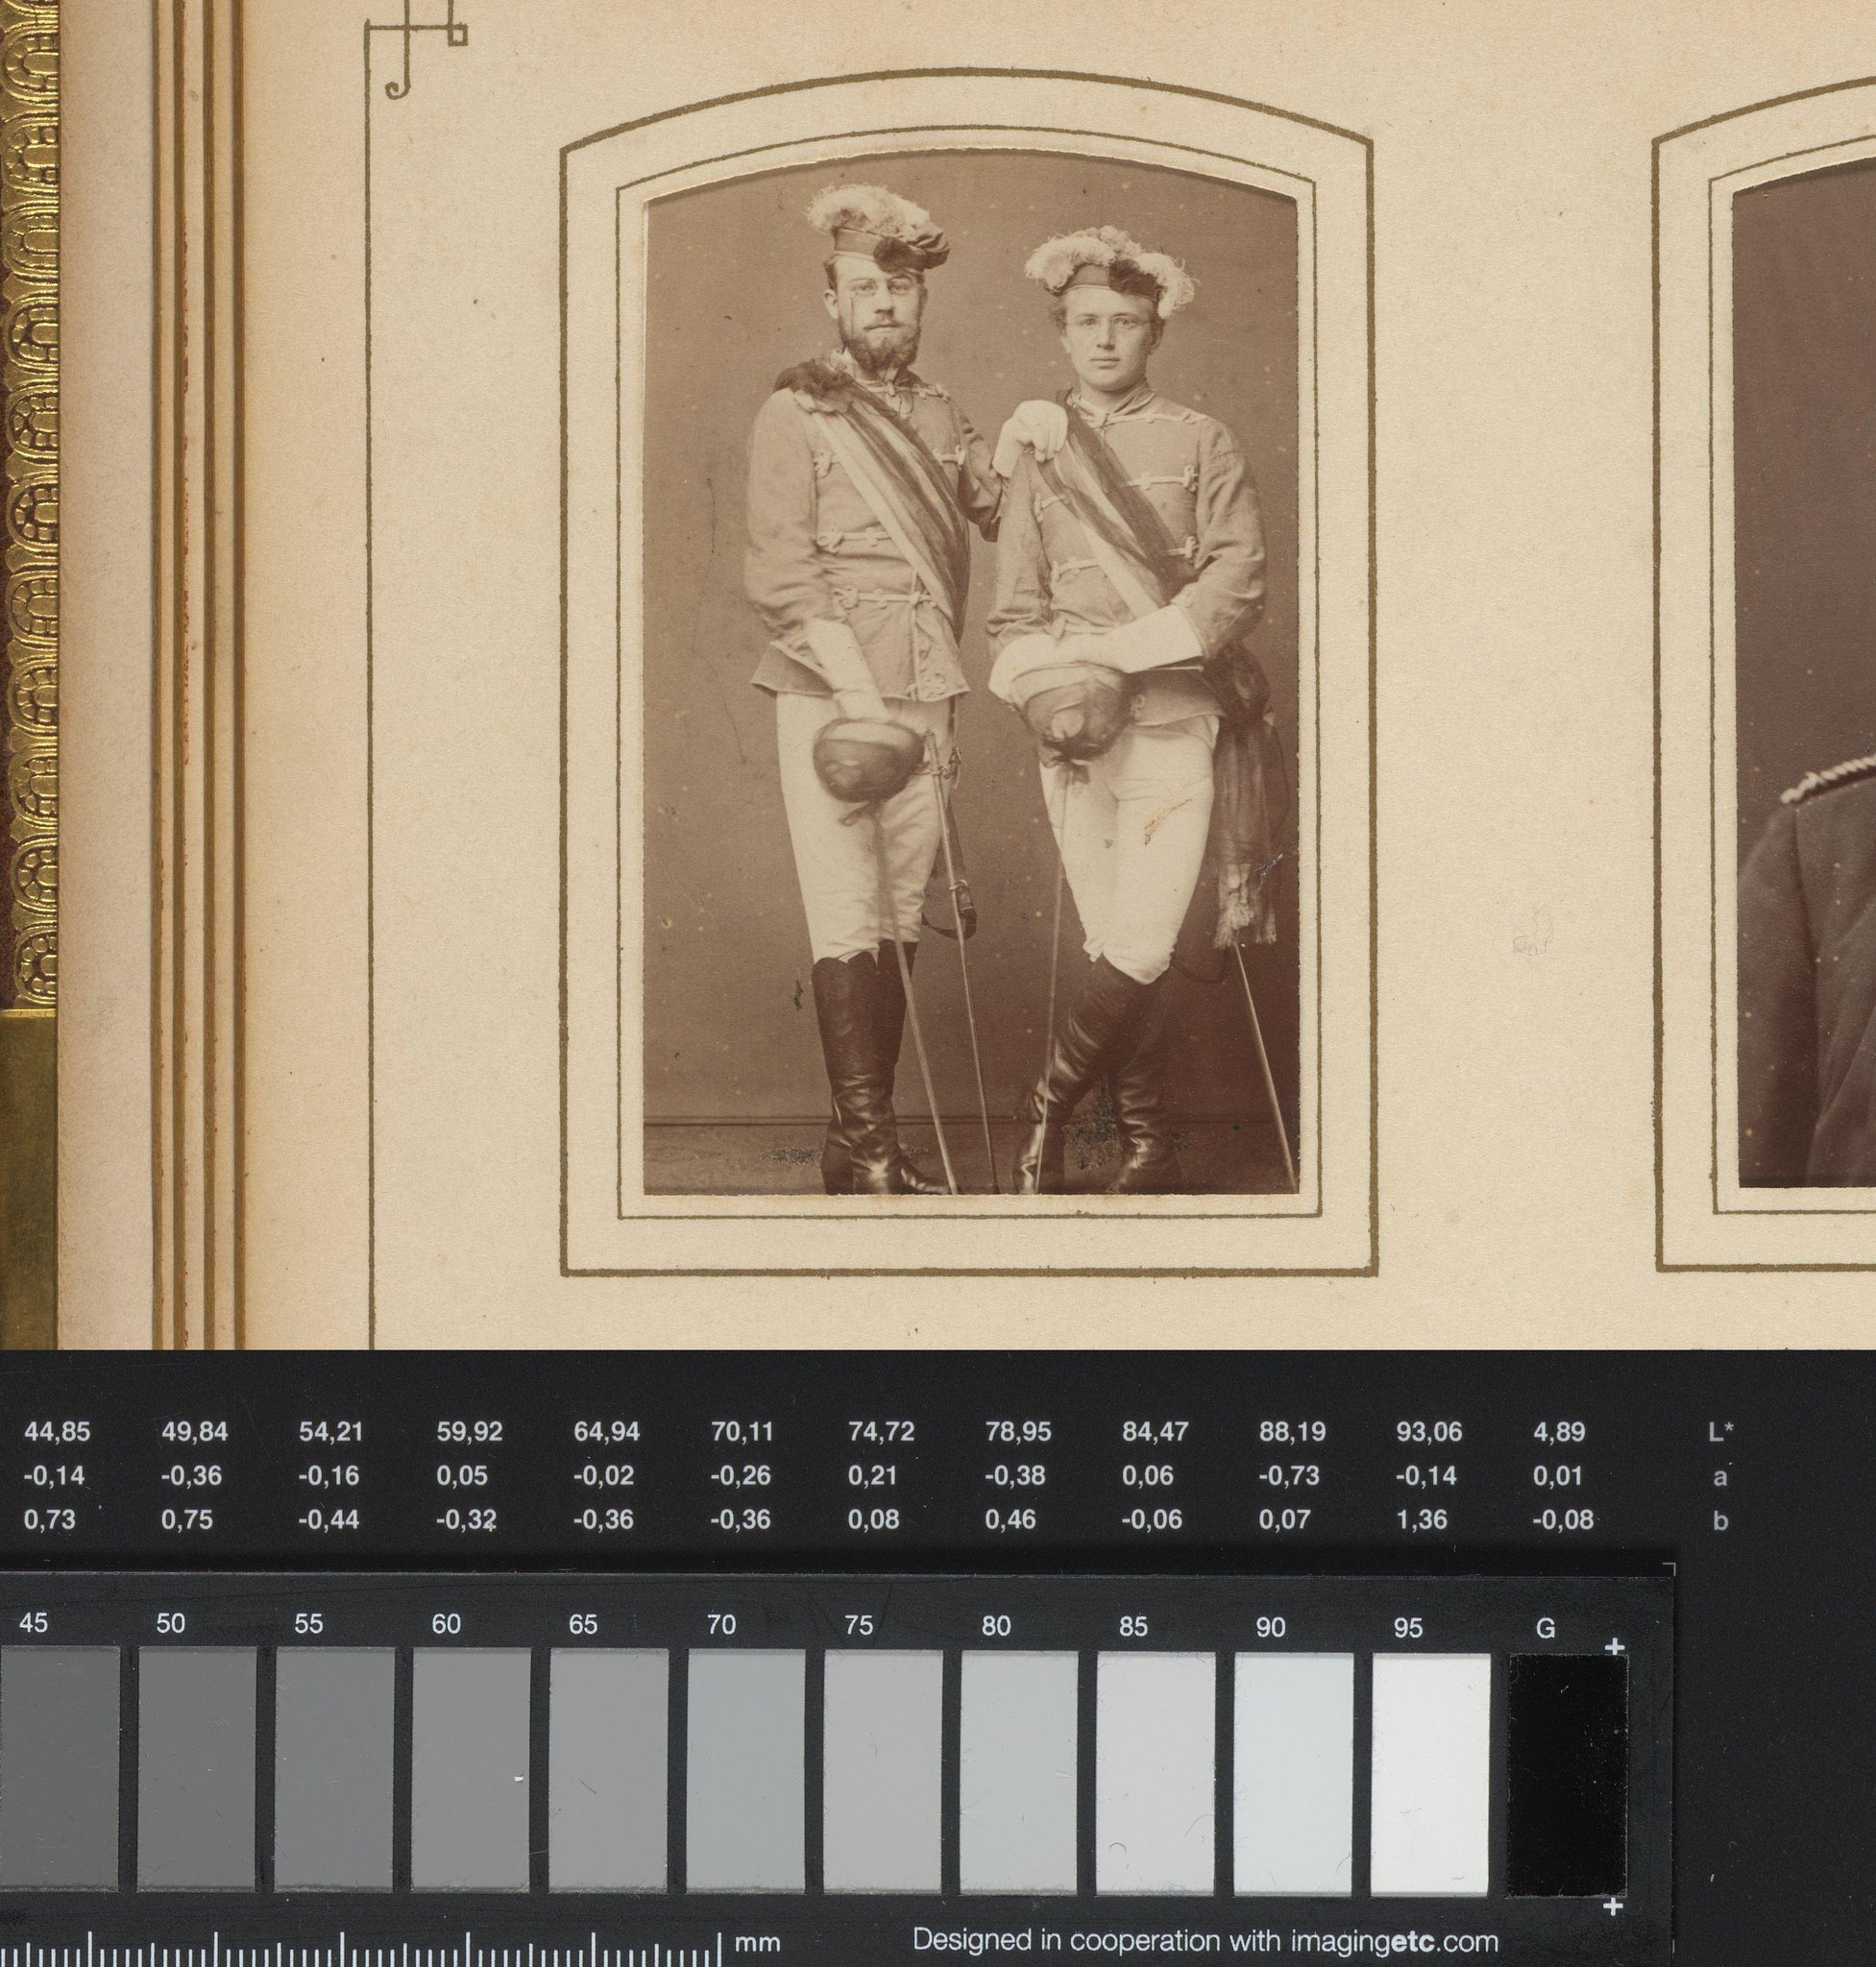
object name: photograph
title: Portret van twee jonge mannen in kostuum met degen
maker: j. westhoven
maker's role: fotograaf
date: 1876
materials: cardboard, photographic support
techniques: albumen print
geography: bonn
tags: youth, young man, adolescent (+ two persons), historical persons, hacking and thrusting weapons: rapier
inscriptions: inscription: ‘J. Westhoven/ MALER u. PHOTOGRAPH./ Bonn/ Franziscanerstrasse No 2./ Die Platte bleibt für Nachbestellungen/ reservirt.’, annotation: ‘H[...]/ [...]/ Scheepes/ z. f. E./ conv. juris[.]/ Otto Hesse/ [...] math[..]/ Carl Westh. [...] astron/ Bonn, d. 5 August/ 1876.’